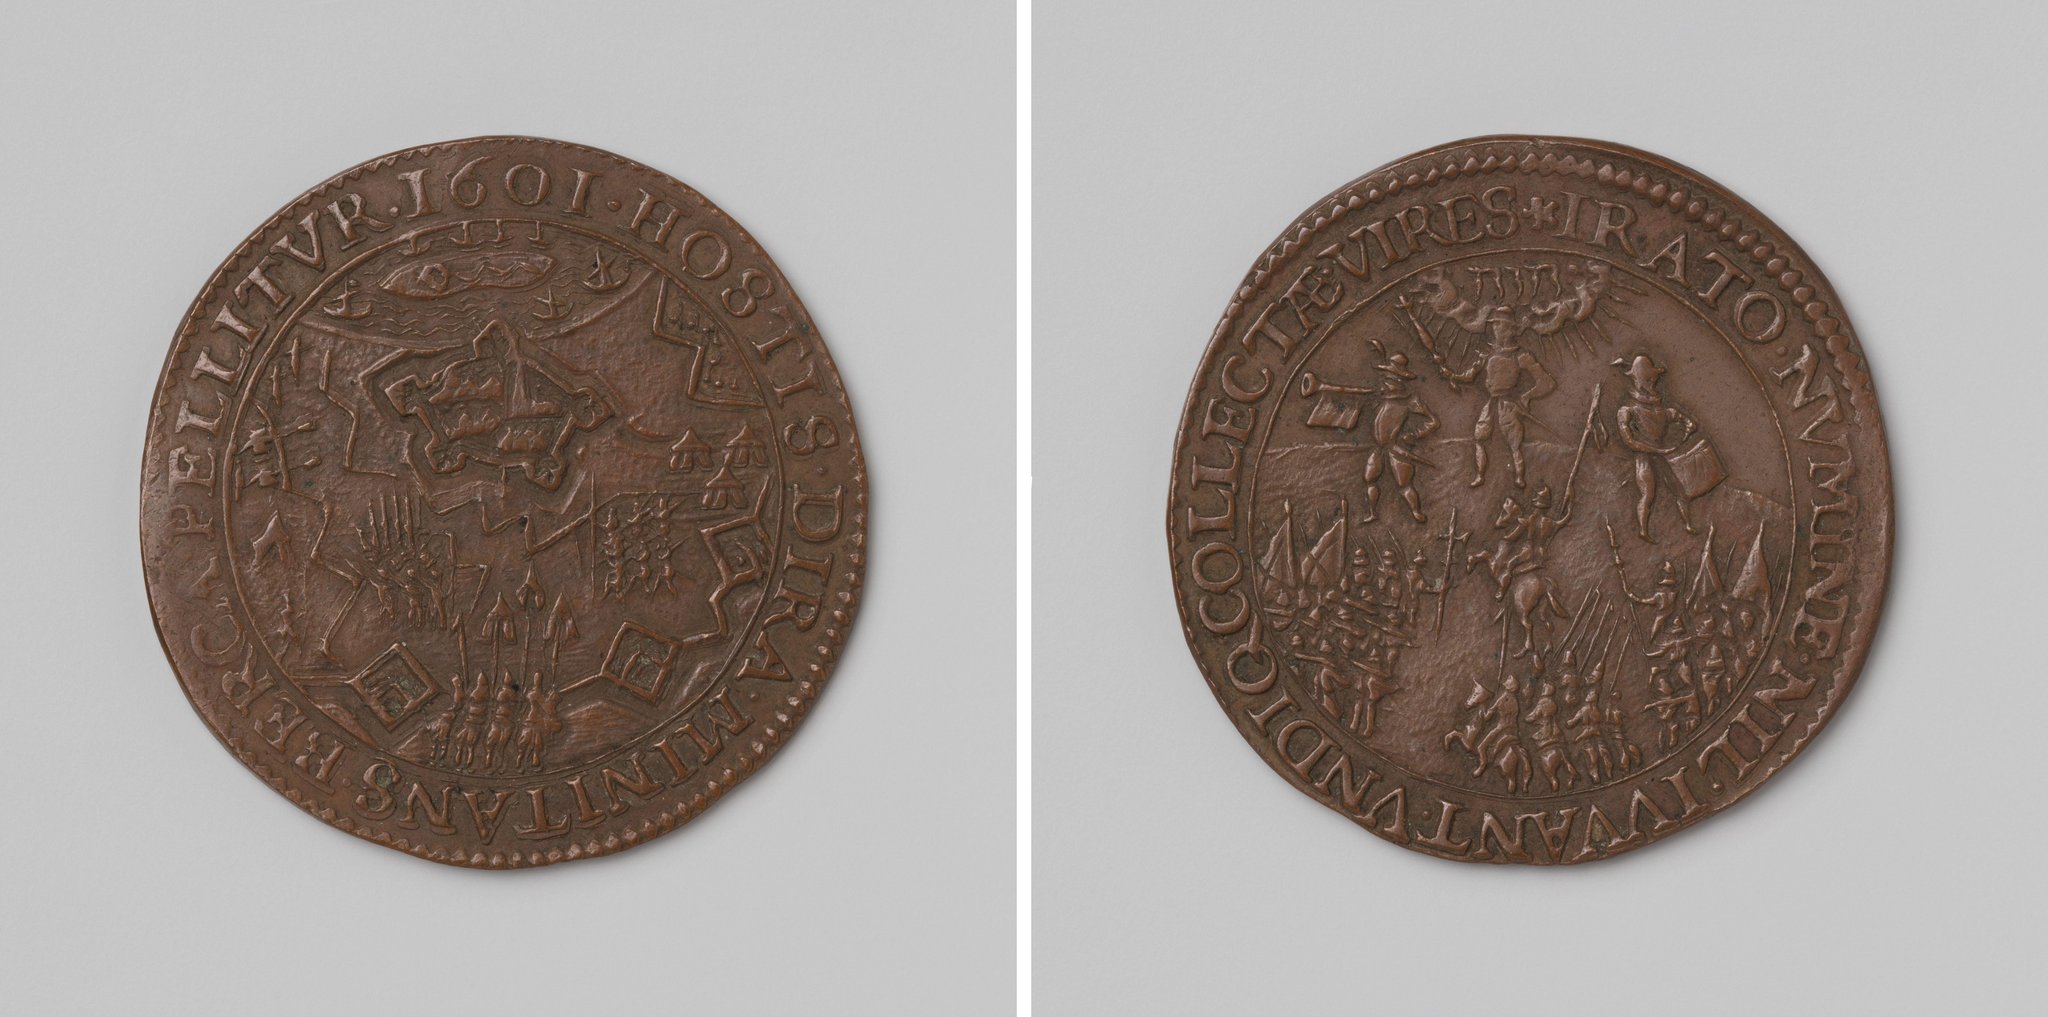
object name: jeton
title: Inname van Rheinberg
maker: Anonymous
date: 1601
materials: copper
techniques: striking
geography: dordrecht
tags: herman graaf van berg, rheinberg, inname van rheinberg (1601)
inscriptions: circumscription: ‘HOSTIS DIRA MINITANS BERCA PELLITVR 1601’, circumscription: ‘IRATO NVMINE NIL IVVANT VNDIQ COLLECTAE VIRES’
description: Koperen penning. Voorzijde: gezicht op stad Rheinberg en schansen van de aanvallers binnen omschrift. Keerzijde: ontzettingsleger van de graaf van Berg, voorafgegaan door tamboer en trompetter, beschenen door hemellicht, waarin naam Jehova in Hebreeuws staat geschreven binnen omschrift.